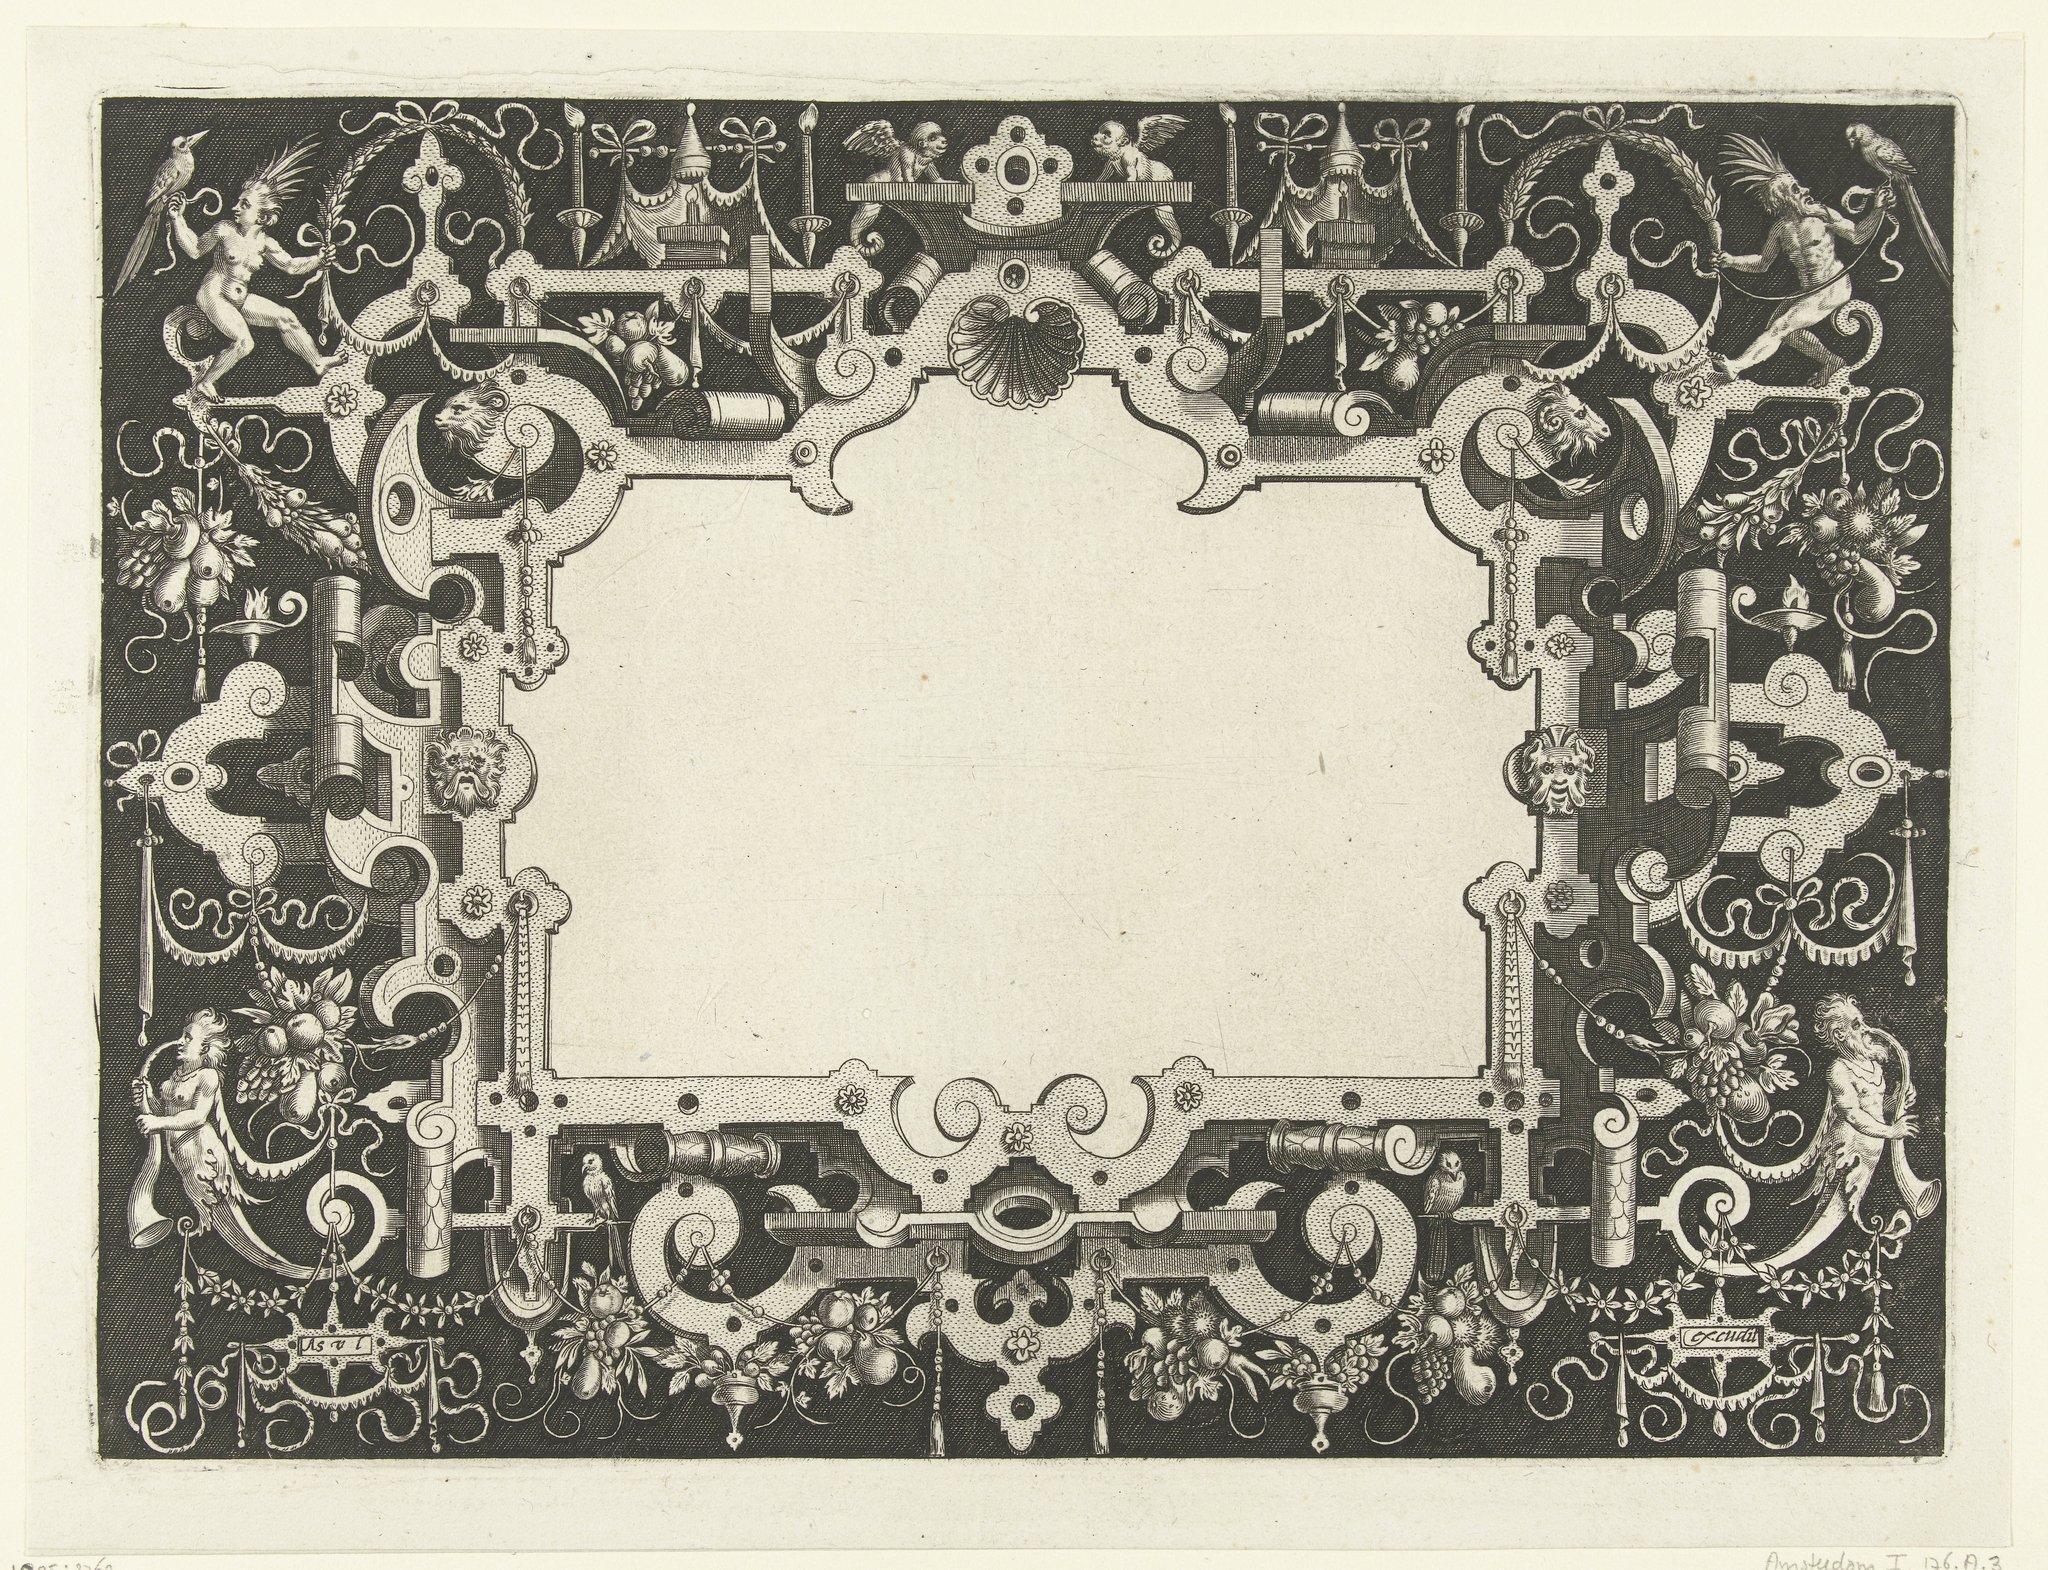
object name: print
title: Cartouches in een omlijsting van rol- en beslagwerk met grotesken, guirlandes en mascarons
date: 1581-1635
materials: paper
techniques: etching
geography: netherlands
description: Het rolwerk loopt linksonder uit in een mannelijke, rechtsonder in een vrouwelijke herme. Beiden blazen wolkjes uit een hoorn die een uitloper van hun neus is. Kopie van blad XV (RP-P-1977-146) van serie met als titel Exercitatio alphabetica nova et utilissima... Gearceerde achtergrond. Een van 6 bladen uit een serie van 8?